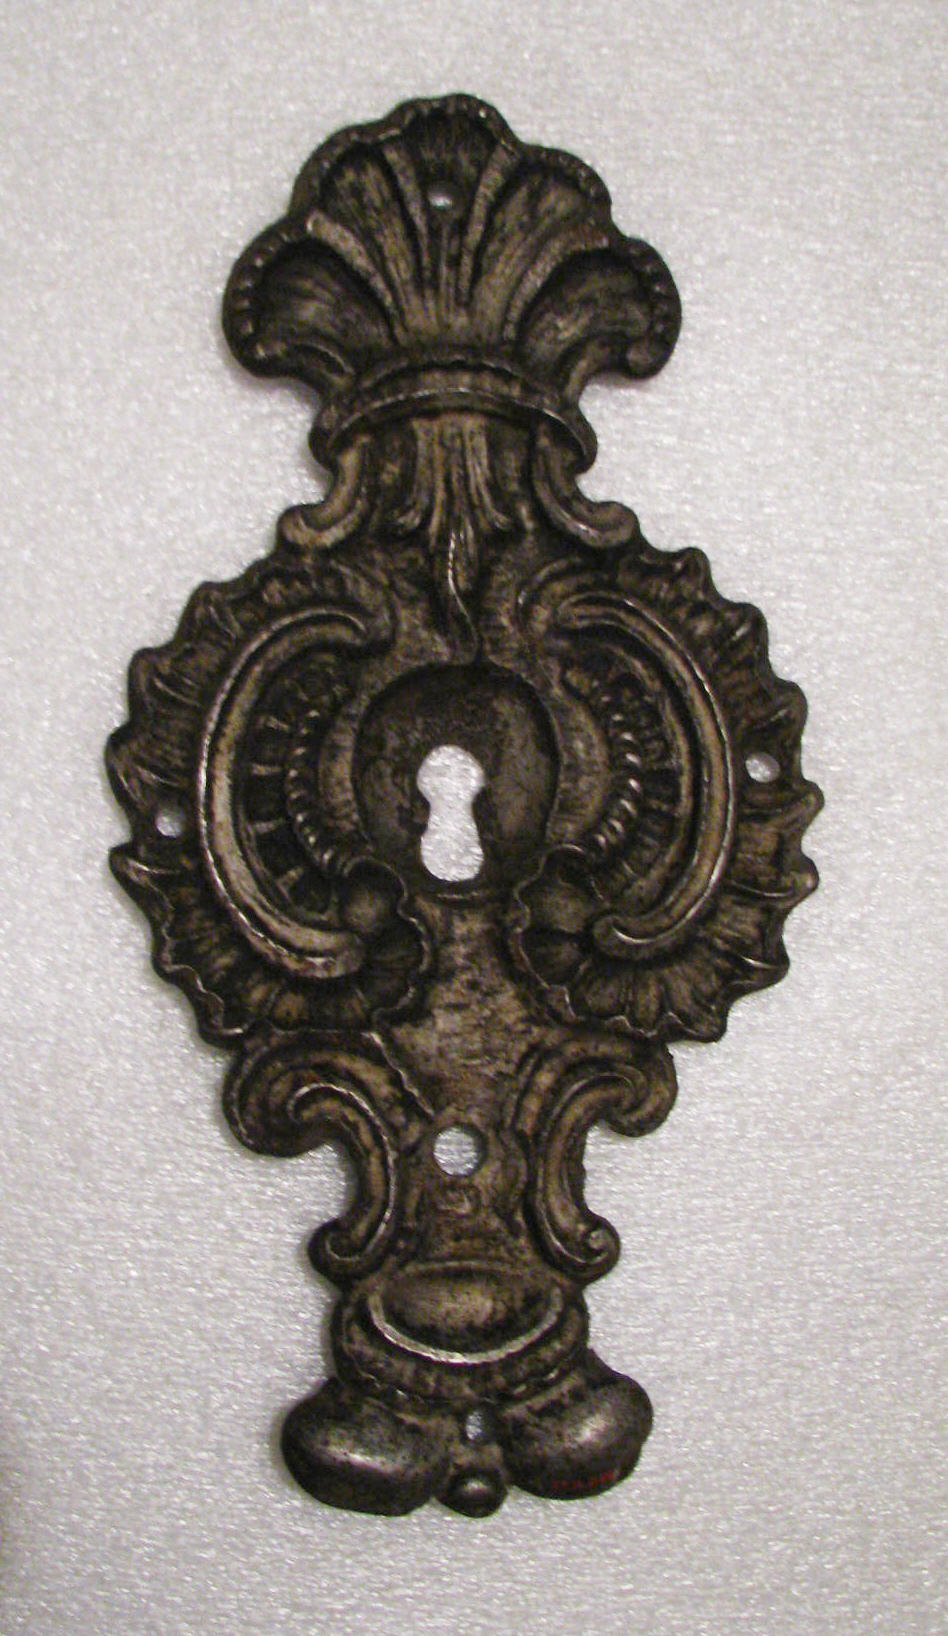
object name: escutcheon with lock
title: Escutcheon of lock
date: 1701-1750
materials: iron